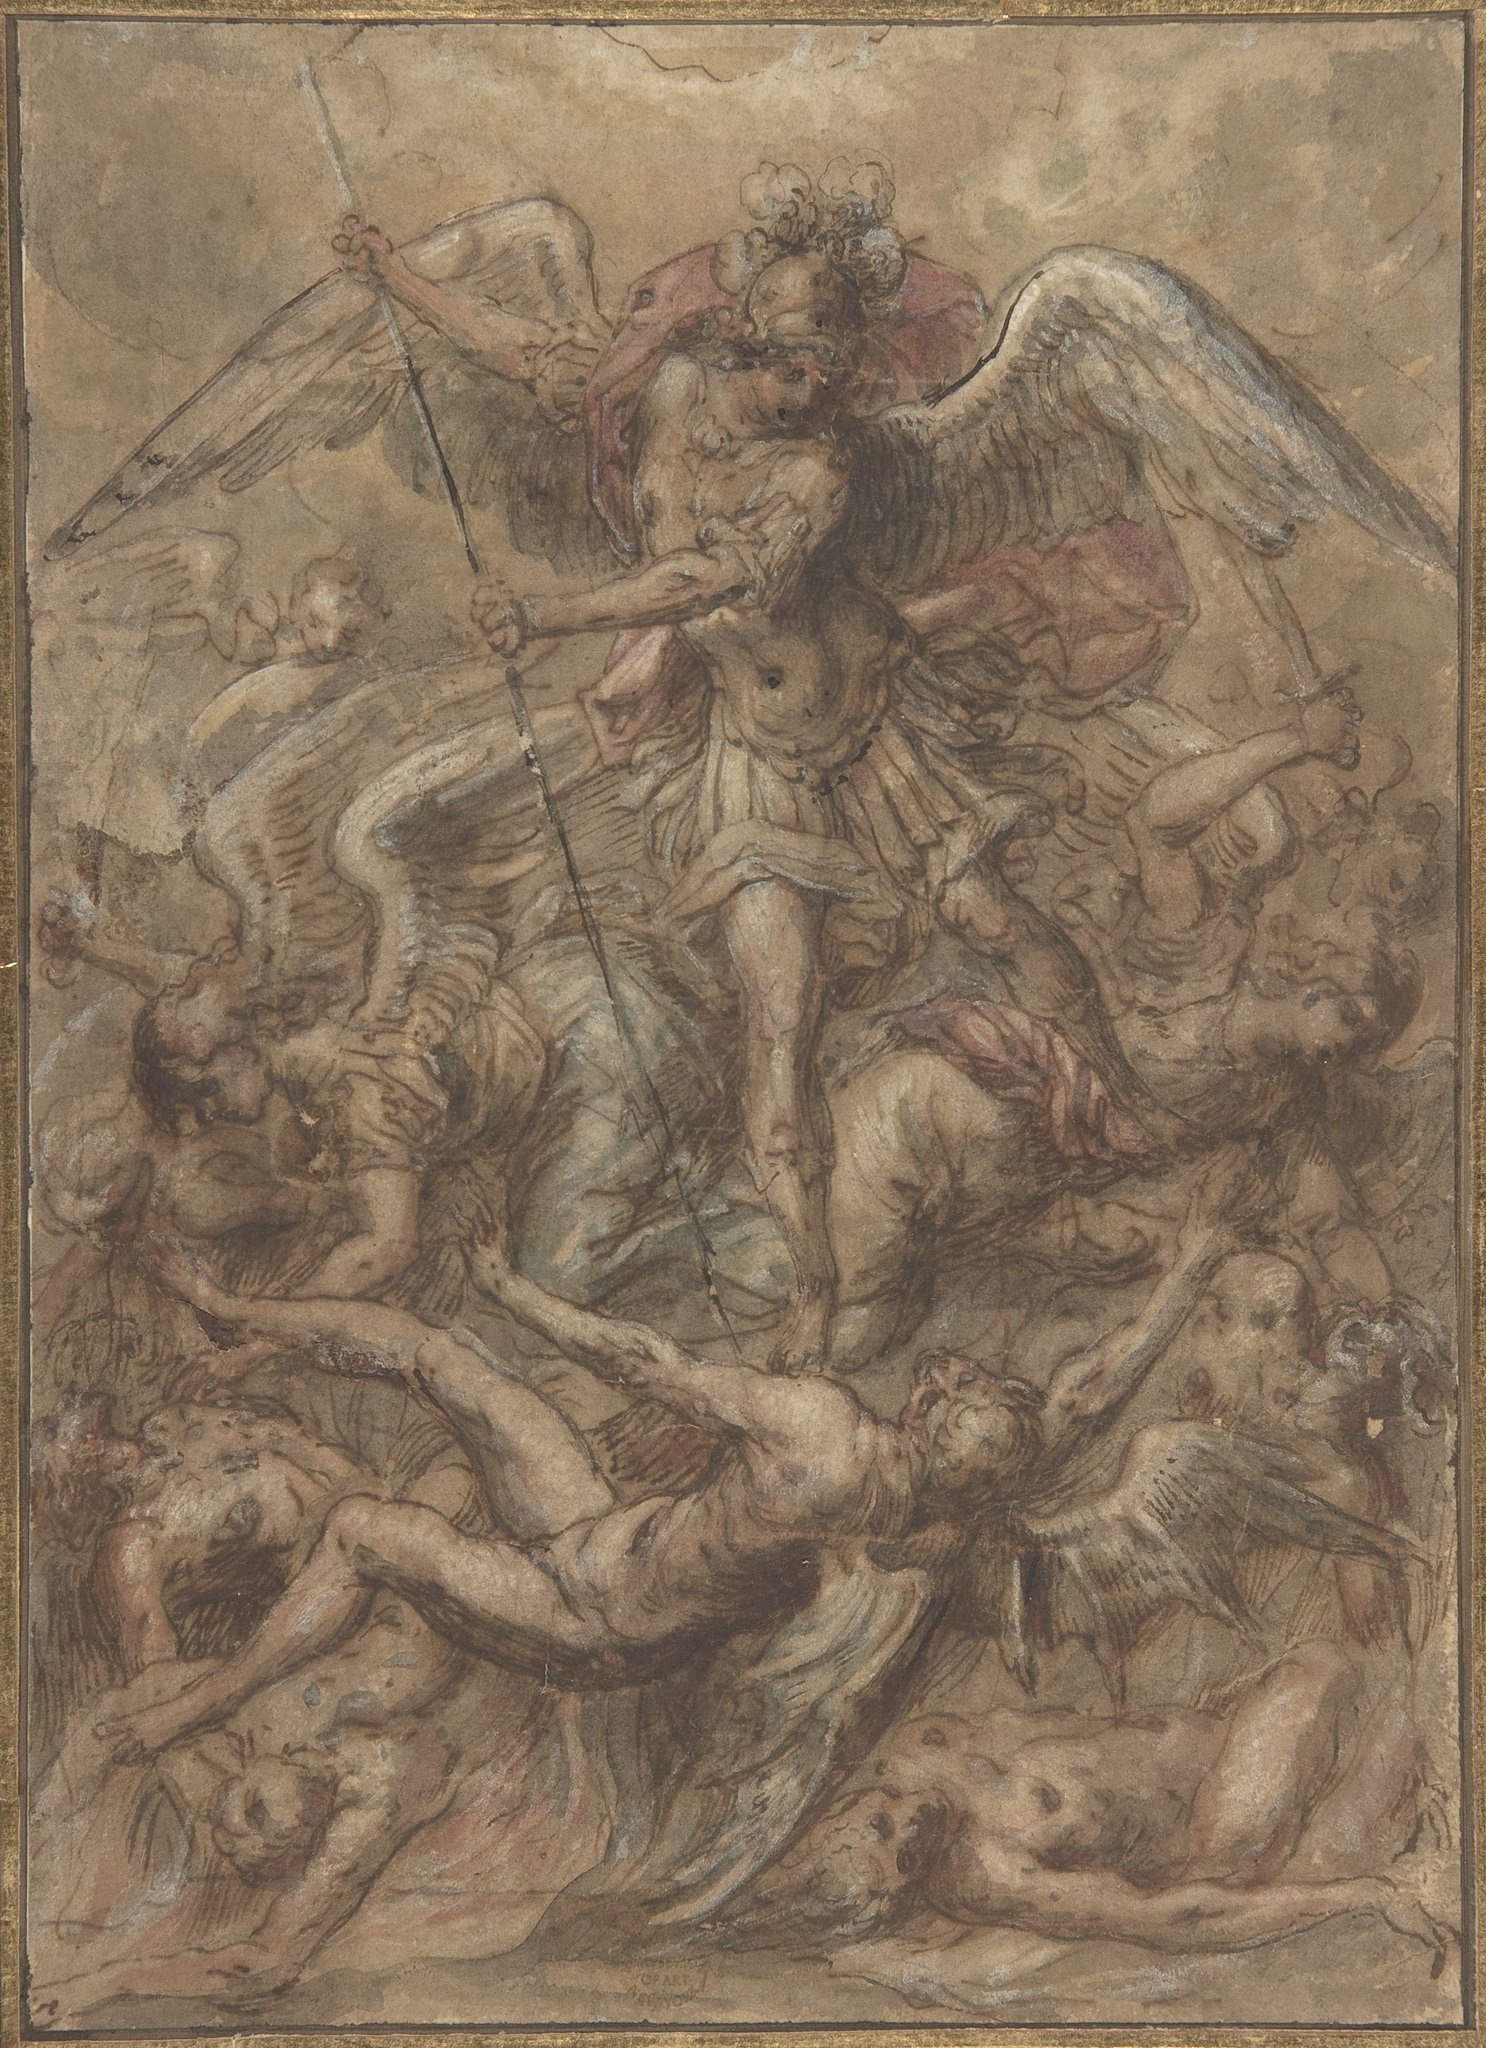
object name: drawing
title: Saint Michael Expelling the Fallen Angels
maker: anonymous, italian, roman-bolognese, 17th century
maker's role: artist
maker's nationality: italian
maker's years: 1600-1700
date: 1501-1600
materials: chalk, gouache, ink, paper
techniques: brush, highlighting, pen, wash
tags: angels,saint michael